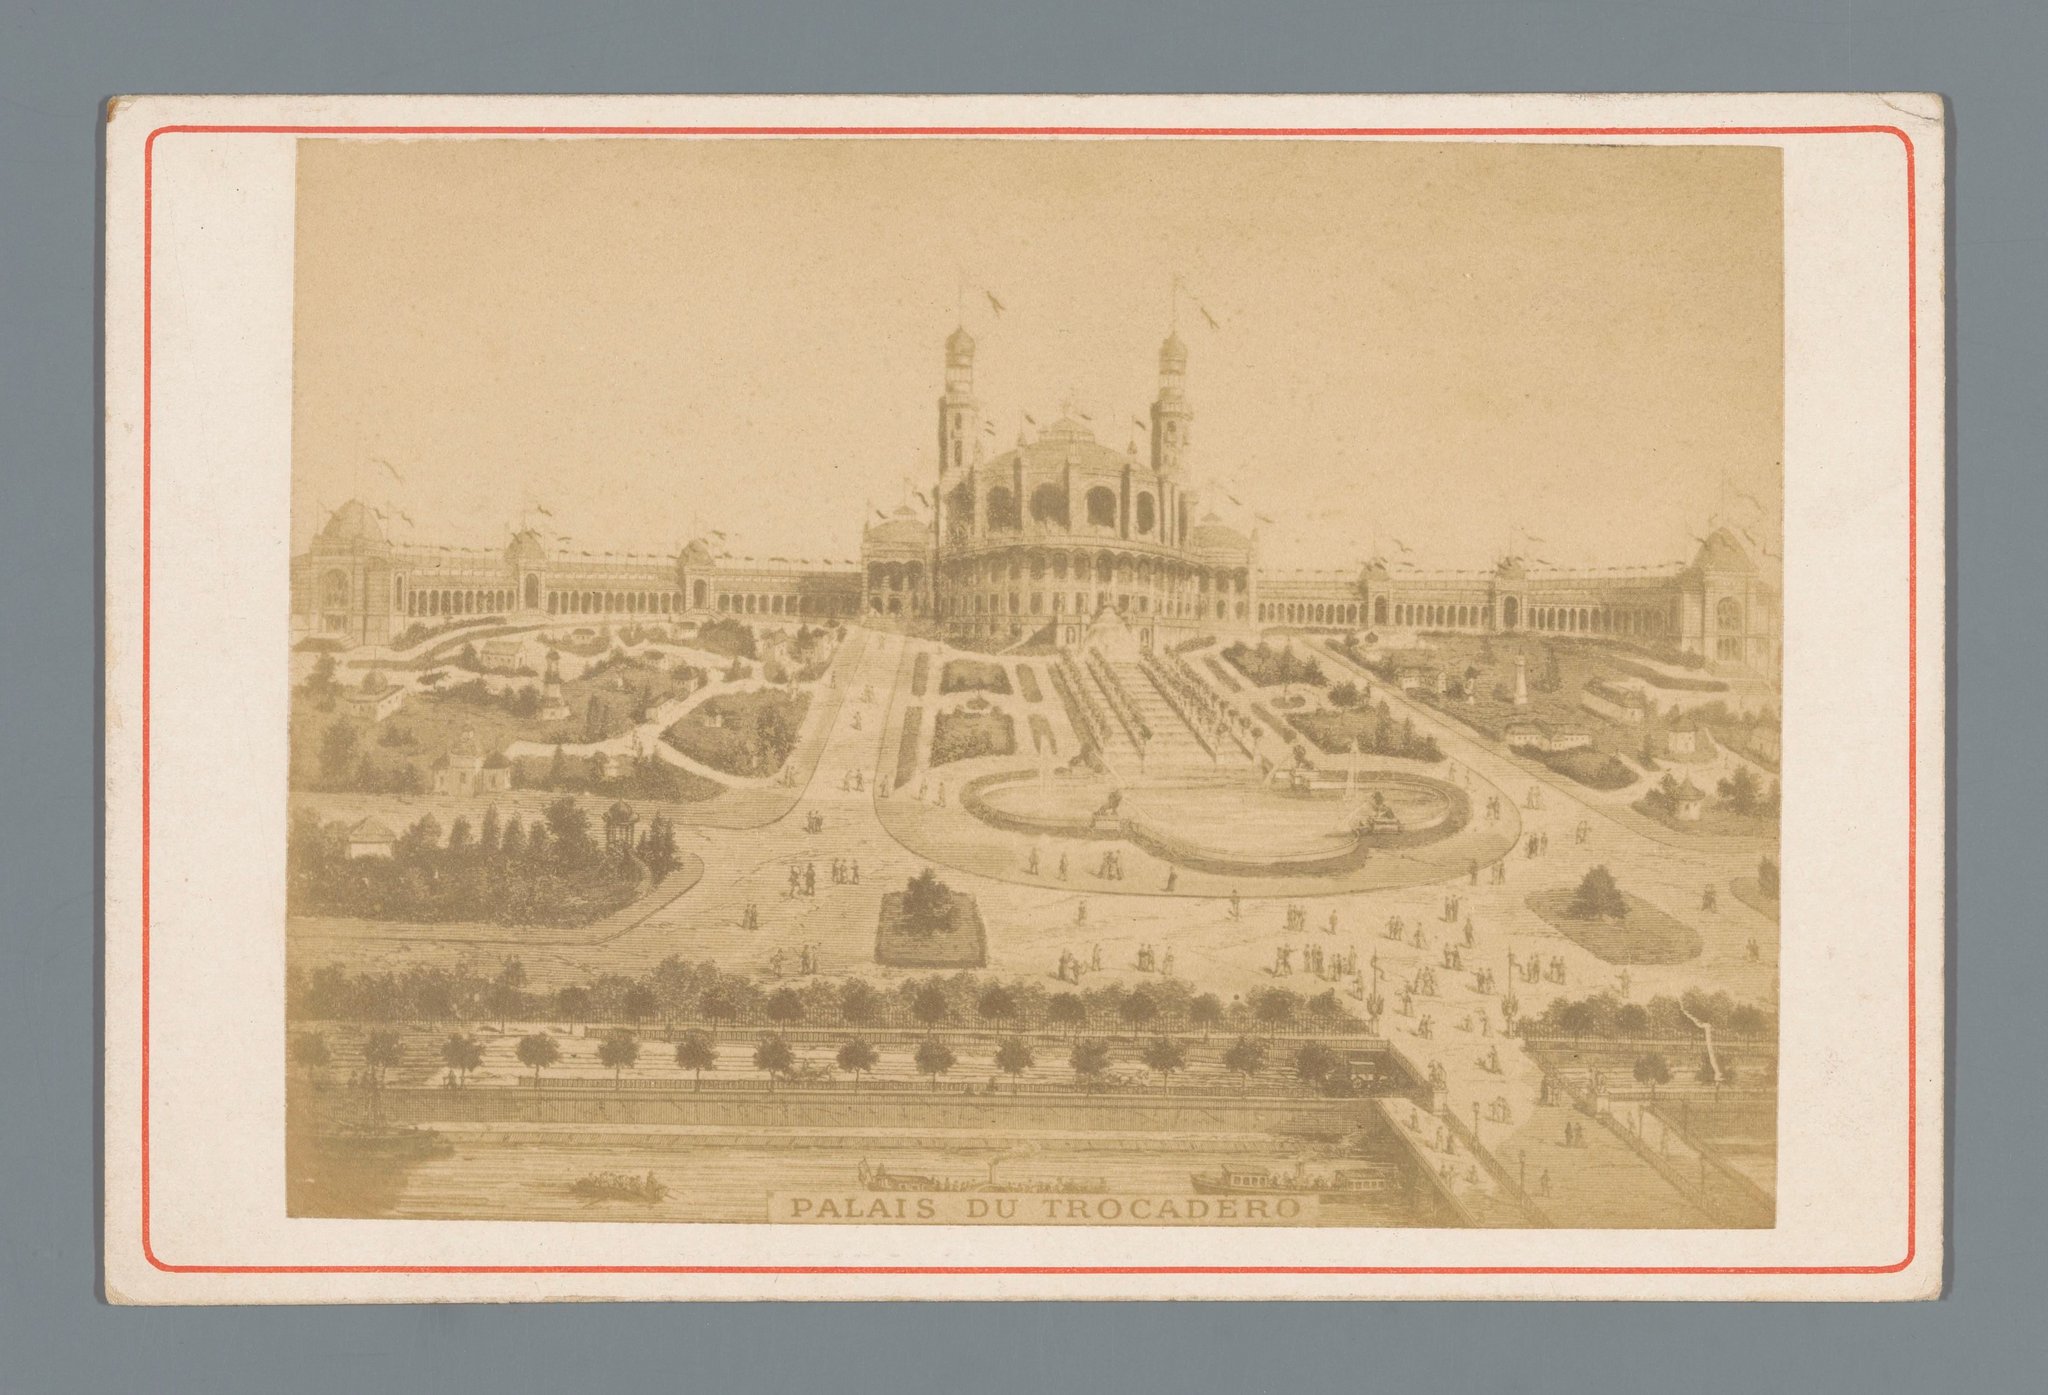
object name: cabinet photograph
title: Fotoreproductie van een prent van een gezicht op het Trocadero te Parijs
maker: Anonymous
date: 1878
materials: cardboard, photographic support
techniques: albumen print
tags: square, place, circus, etc., palace